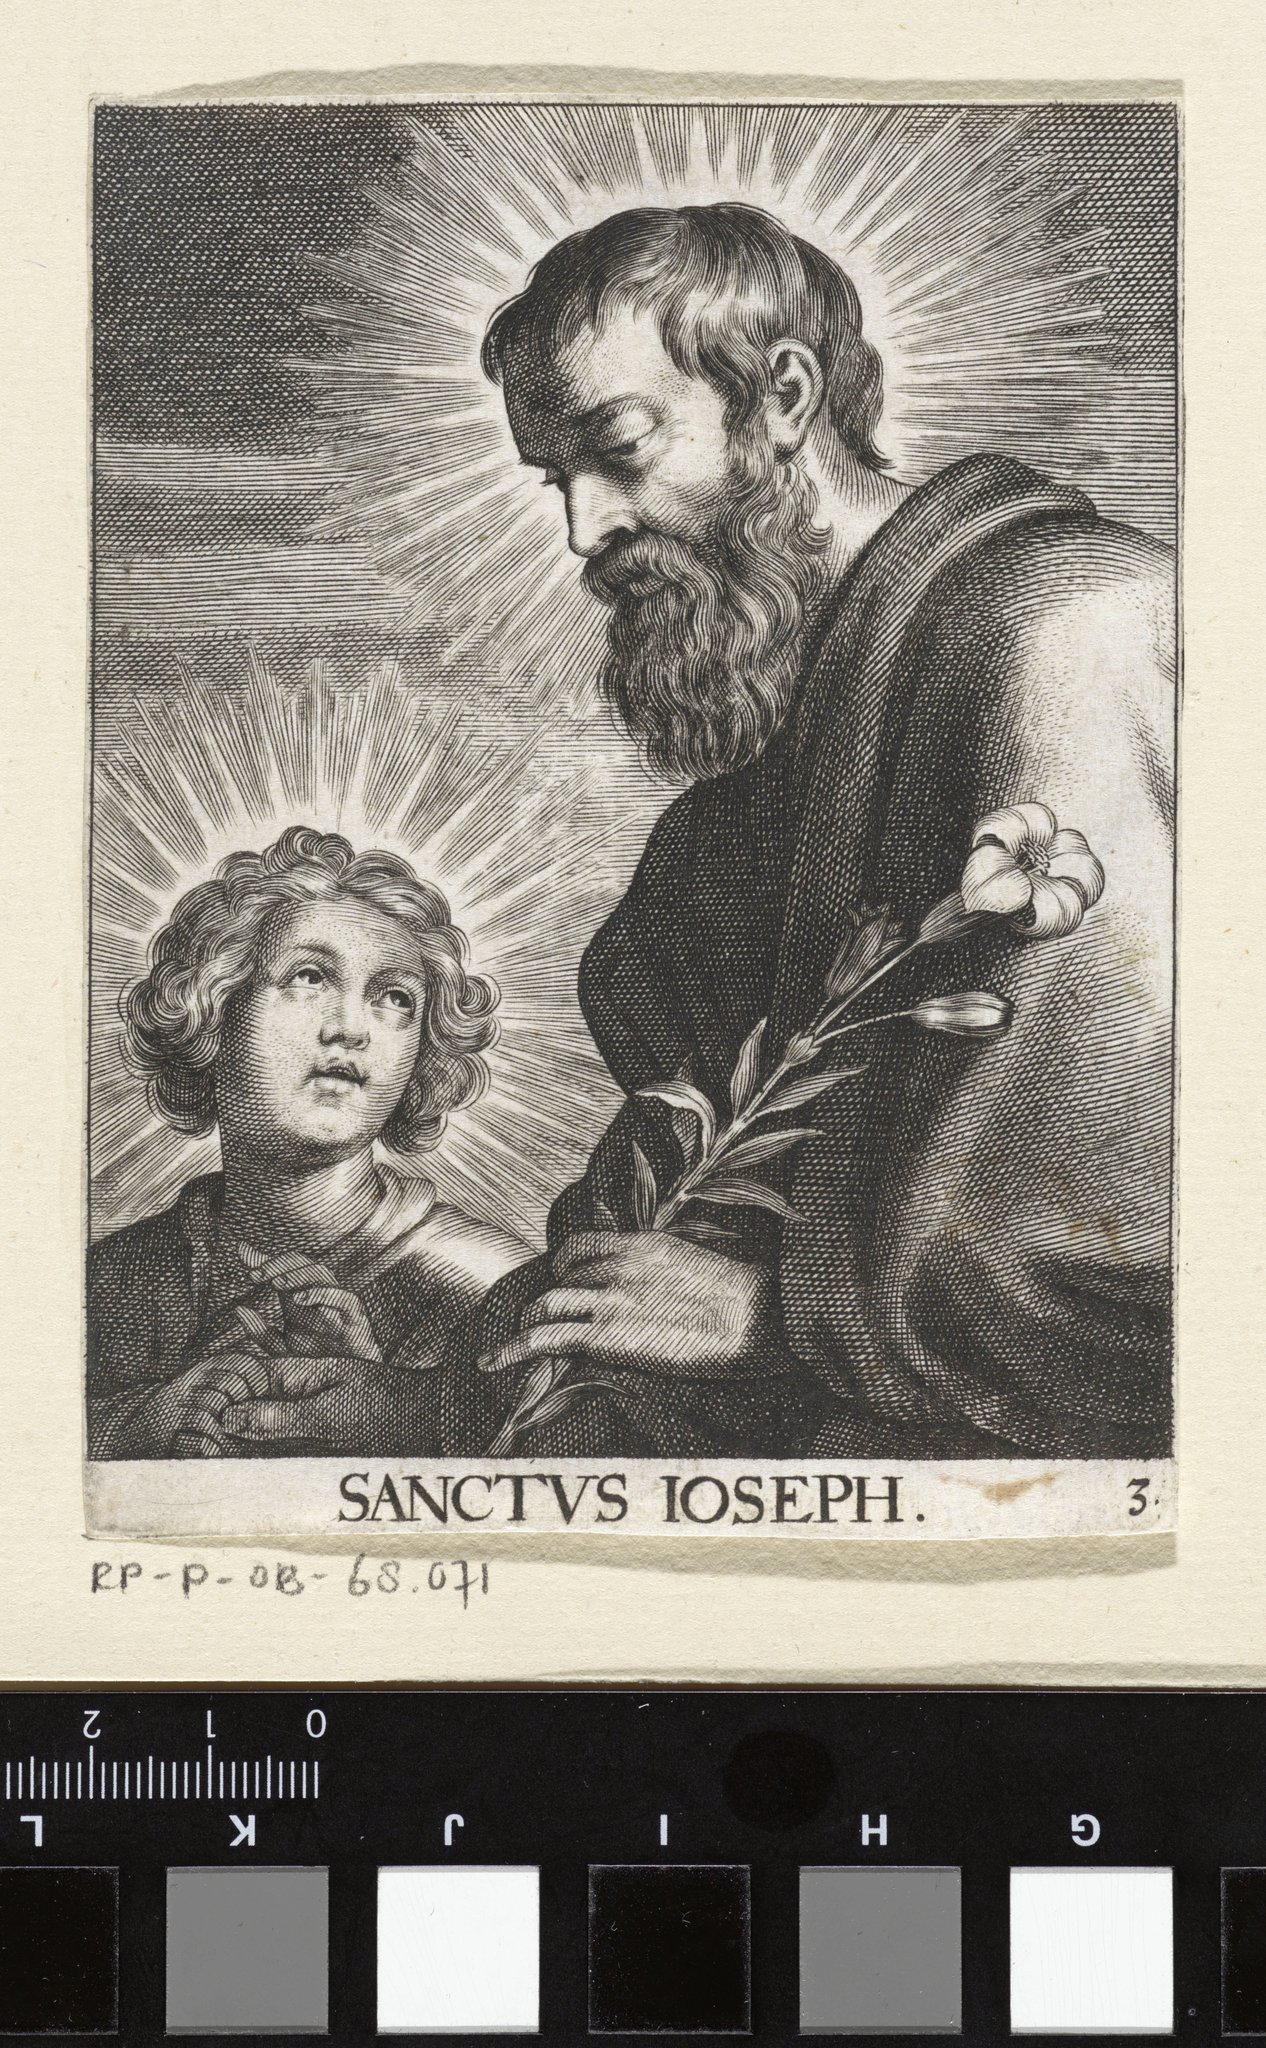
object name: print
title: H. Jozef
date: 1637-1666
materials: paper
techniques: engraving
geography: nuremberg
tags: st. joseph as foster-father of christ, holding the child in his arms or leading him by the hand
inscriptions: collector's mark: Lugt 240, collector's mark: Lugt 240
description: Jozef, de pleegvader van Christus, heeft een lelie als symbool van zuiverheid in zijn hand. Bij hem staat het Christuskind, wiens hand hij vasthoudt.